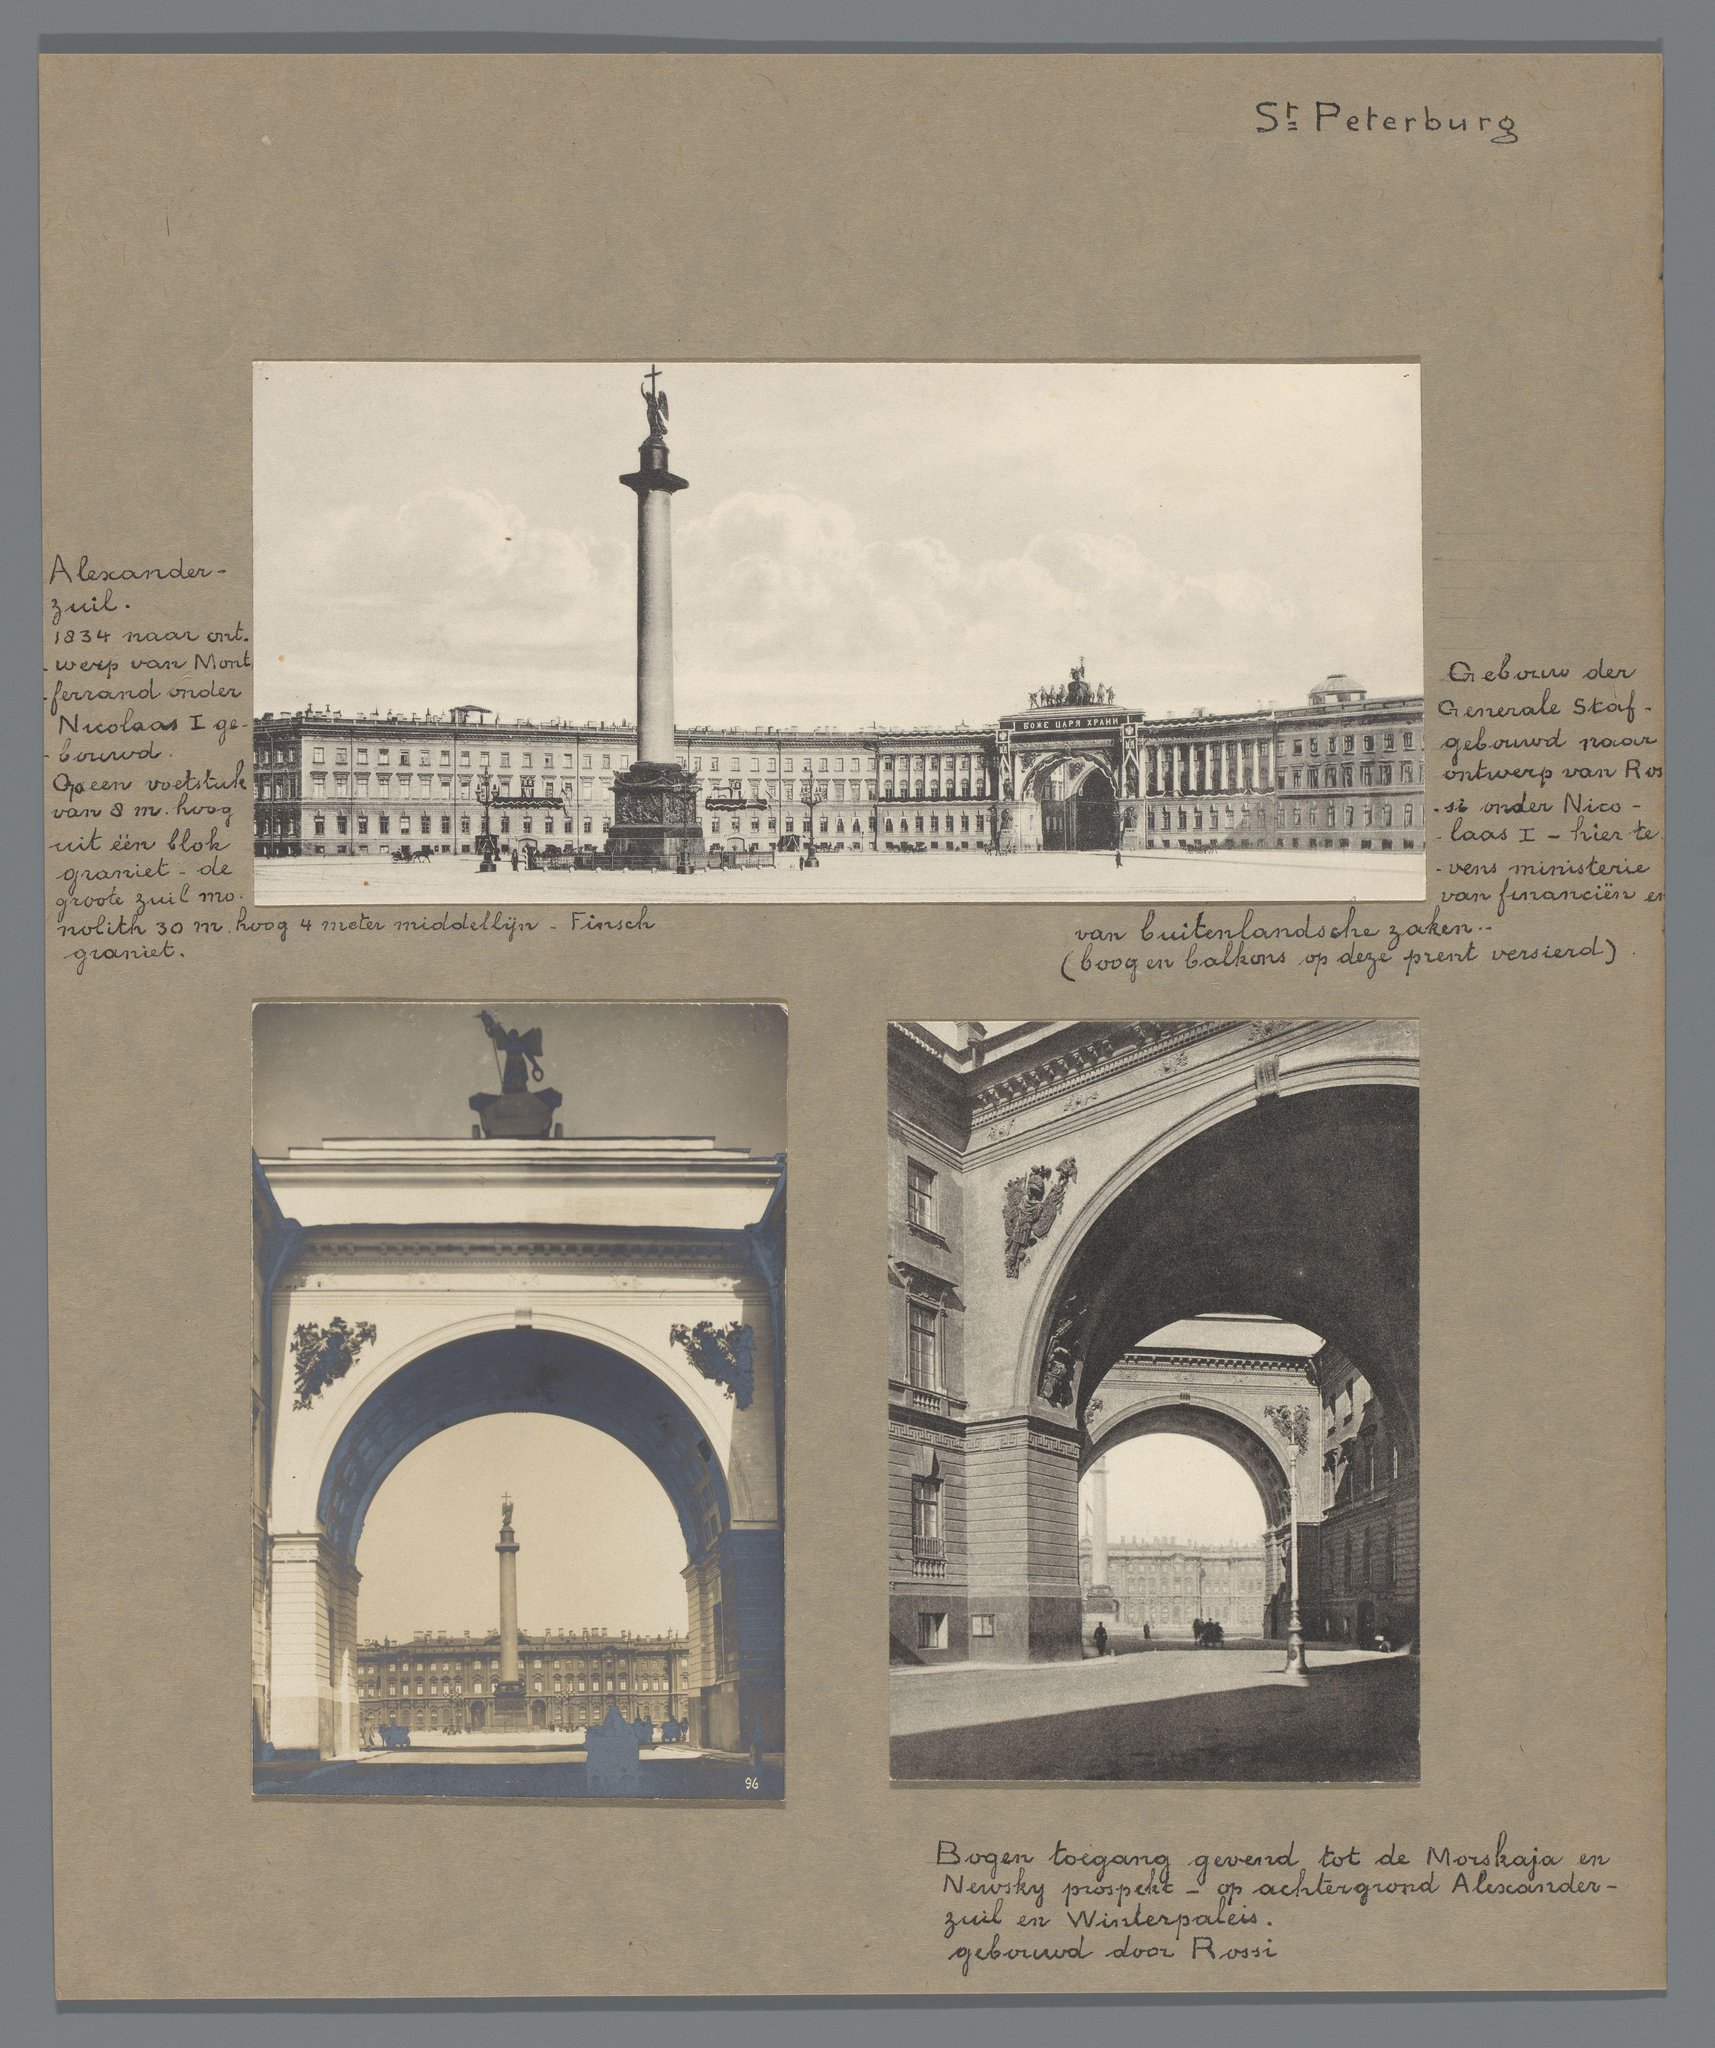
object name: photograph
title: St. Petersburg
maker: Anonymous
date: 1880-1930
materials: photographic support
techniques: photograph, gelatin silver print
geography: russia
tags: sint-petersburg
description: Drie foto's van Sint-Petersburg op drager.